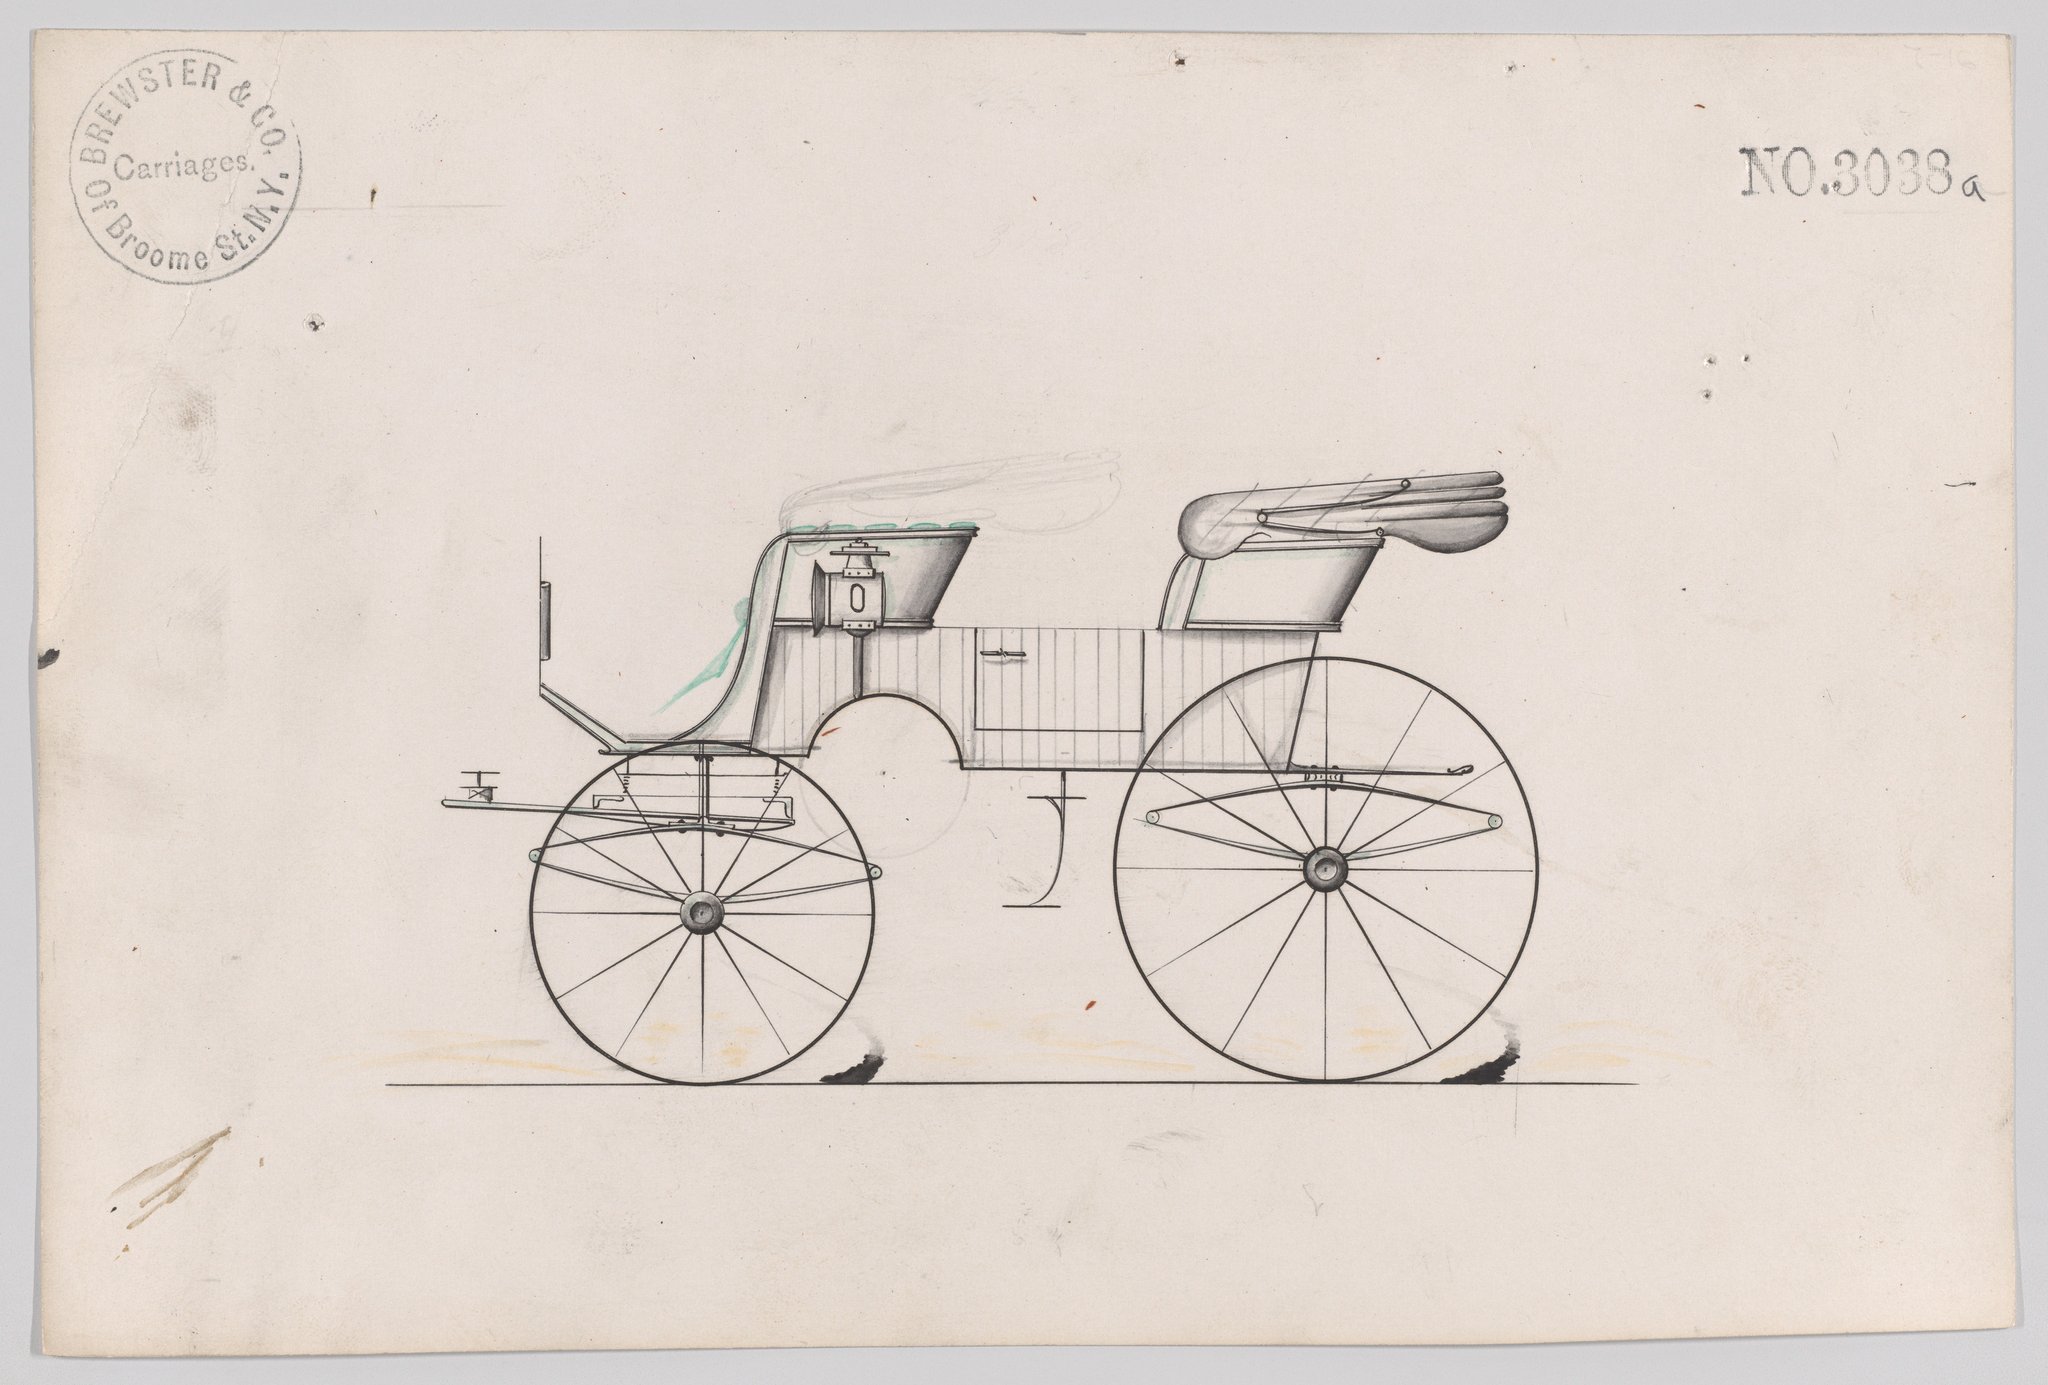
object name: drawing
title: Design for 2 seat Phaeton, no. 3038a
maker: brewster & co.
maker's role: manufacturer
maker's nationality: american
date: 1874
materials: graphite, ink, pencil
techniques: pen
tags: carriages